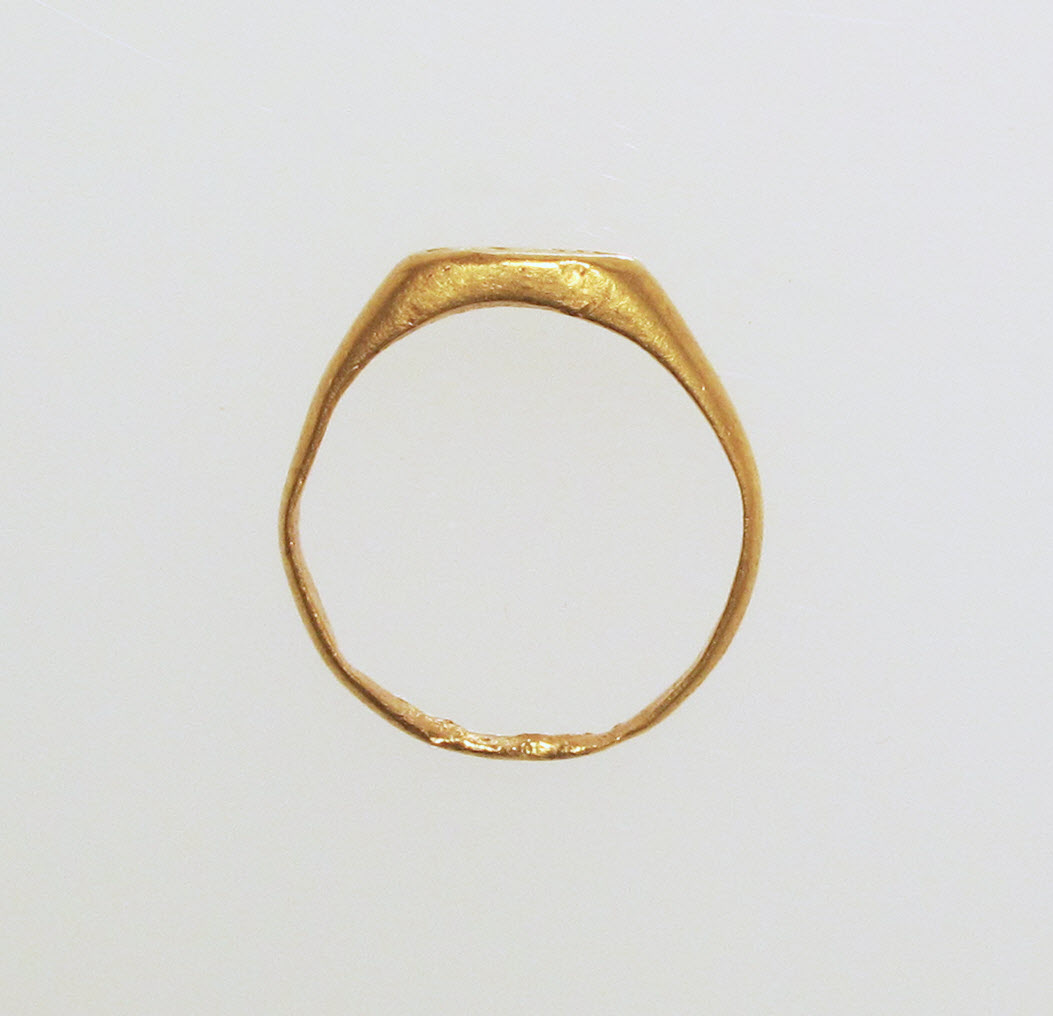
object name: ring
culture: roman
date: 100 BCE-300 CE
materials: gold